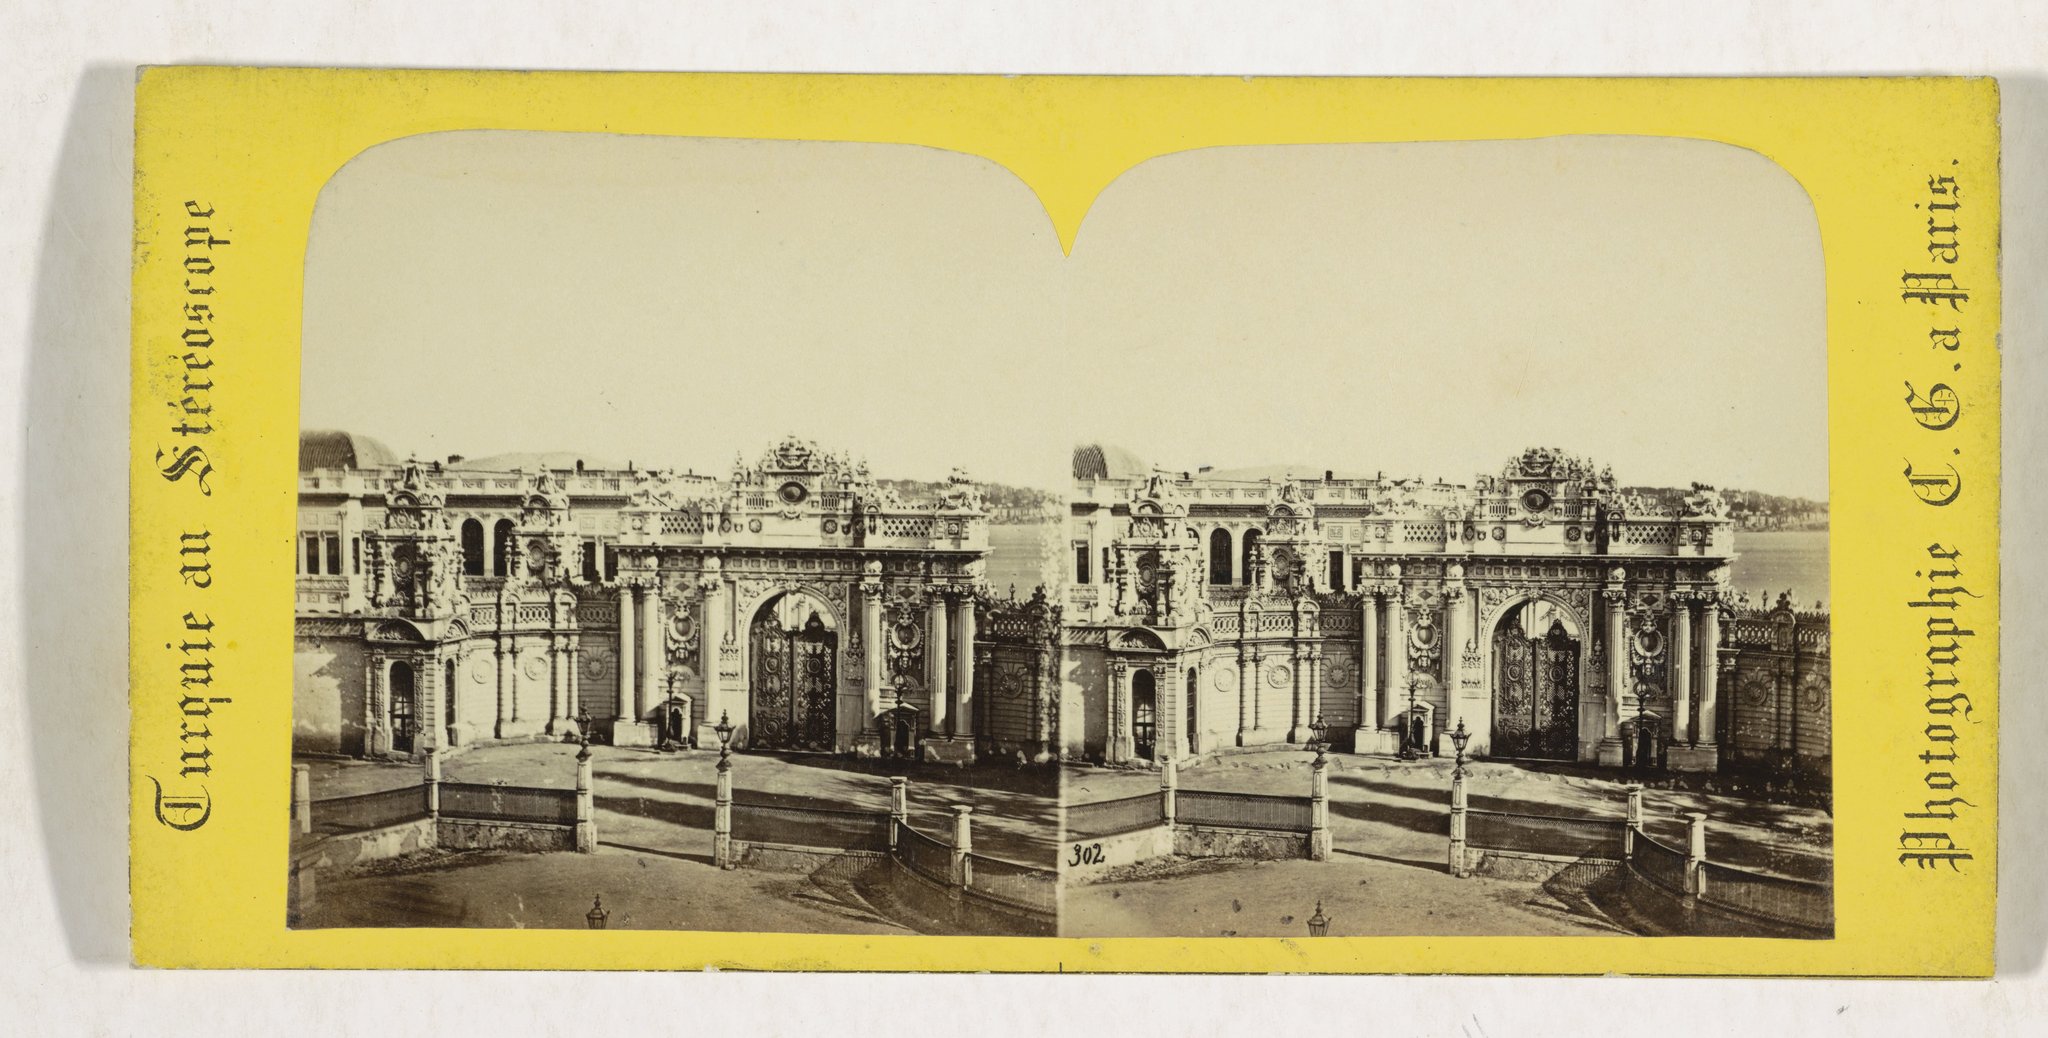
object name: stereograph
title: Entree van het Dolmabahçepaleis, Istanboel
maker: charles gaudin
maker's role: publisher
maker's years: 1825-1905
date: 1861-1870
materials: cardboard, paper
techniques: albumen print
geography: dolmabahçepaleis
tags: palace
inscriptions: number: ‘302’